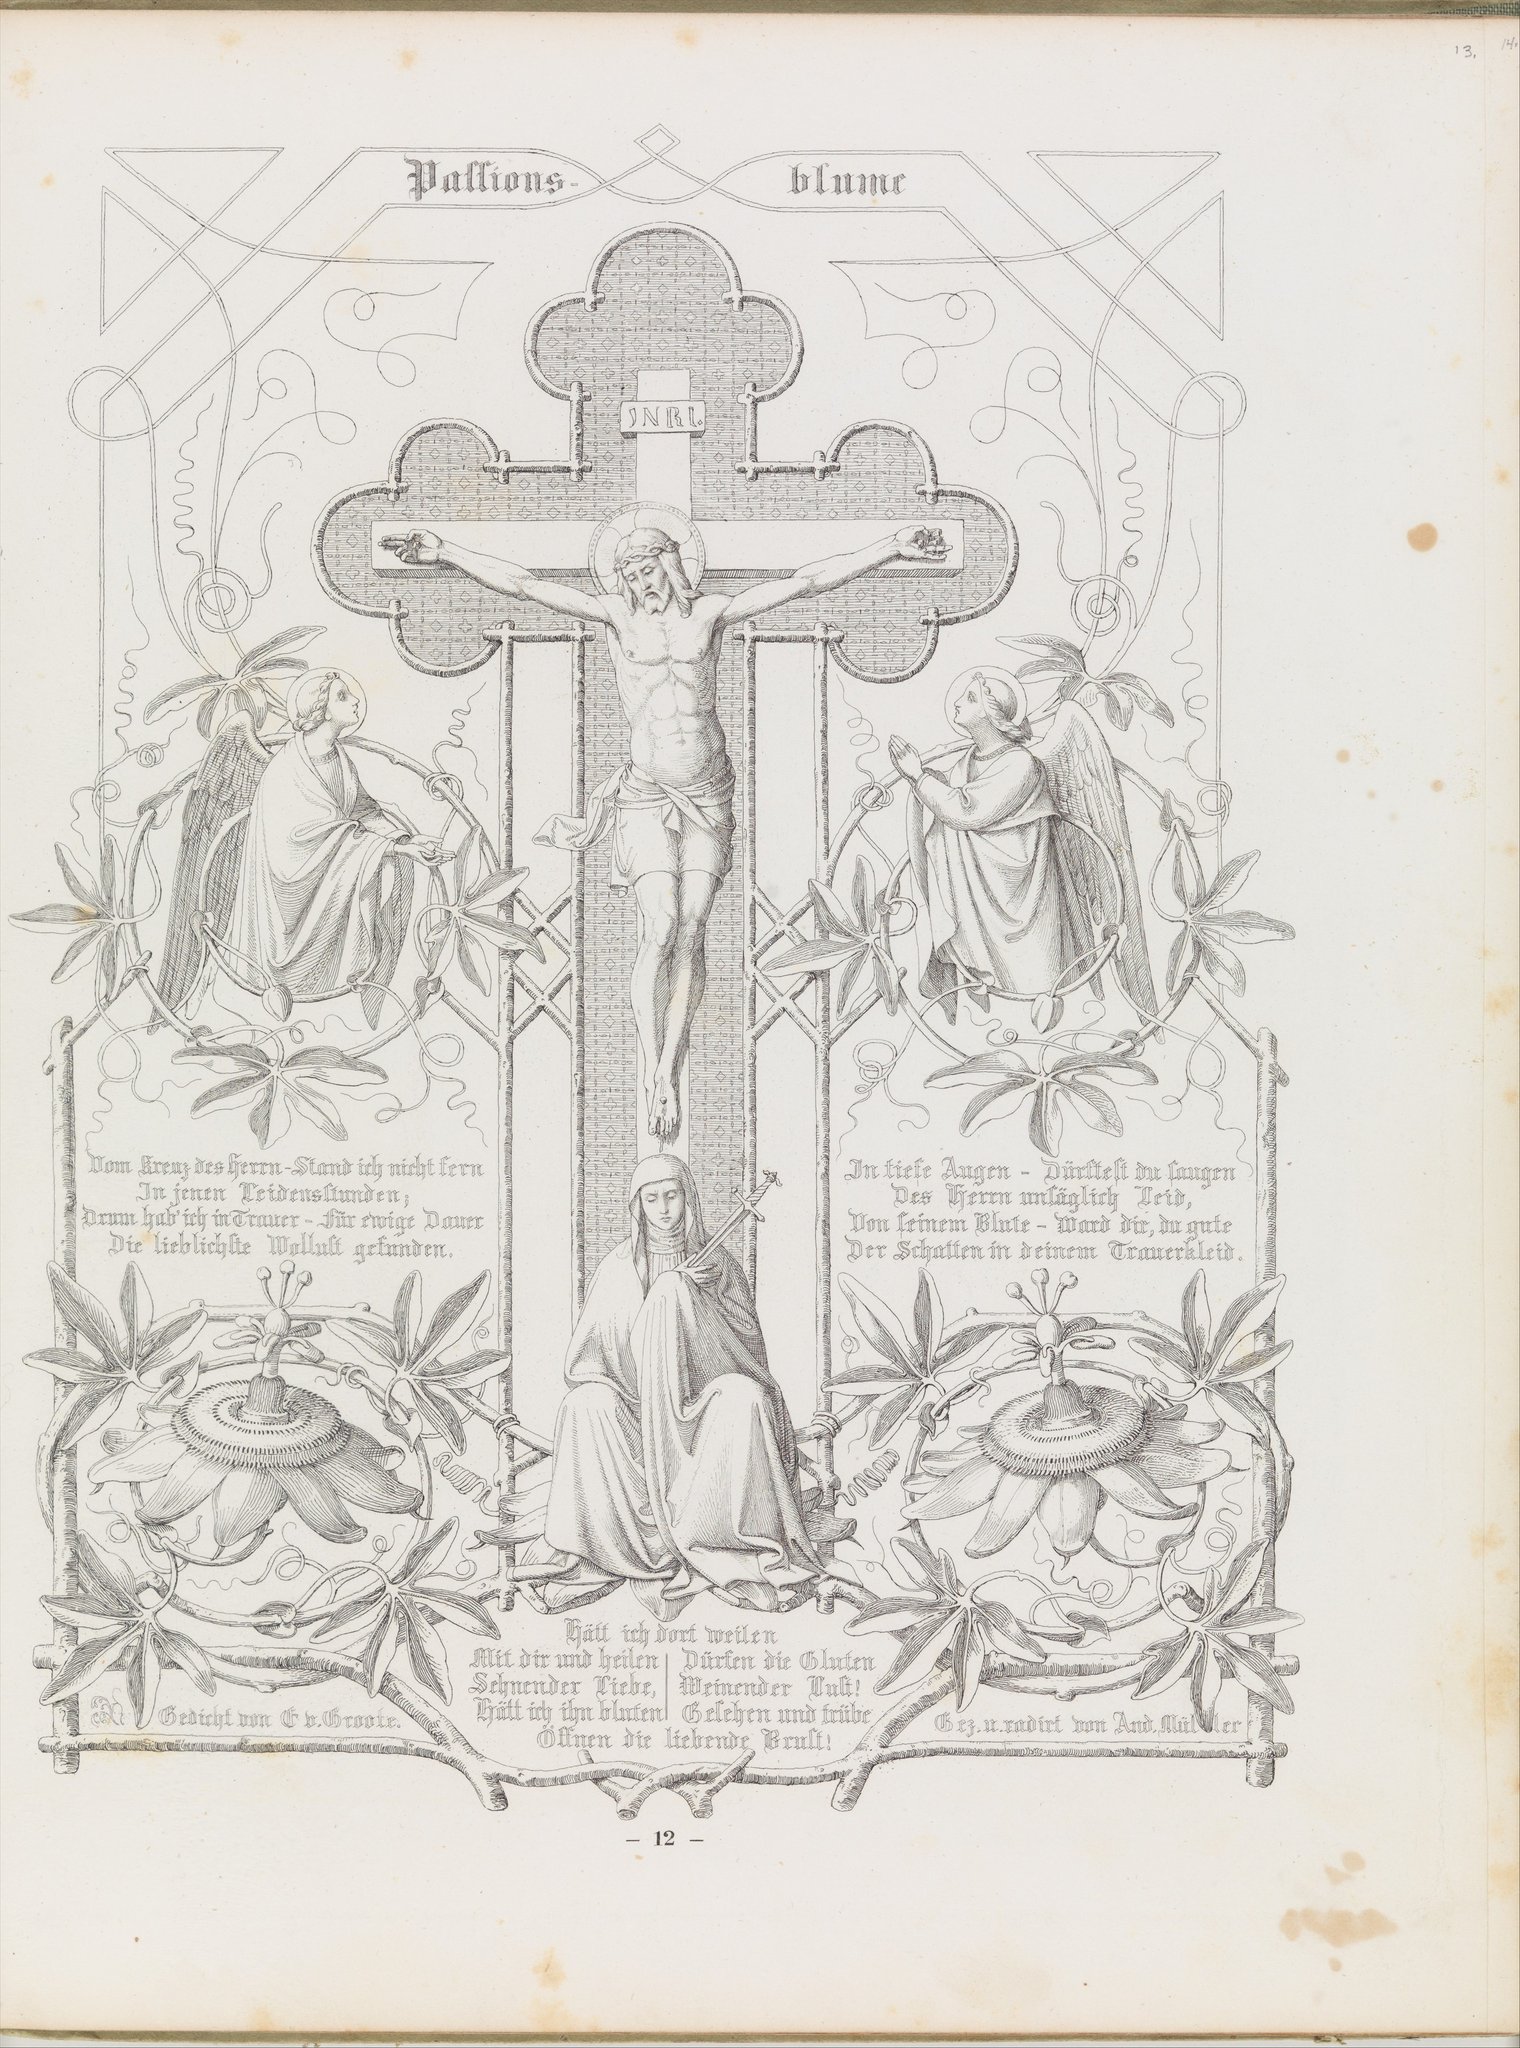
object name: book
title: Deutsche Dichtungen mit Randzeichnungen Deutscher Künstler. I. Band (Lider und Bilder, II)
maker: wilhelm camphausen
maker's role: artist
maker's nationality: german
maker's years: 1818-1885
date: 1843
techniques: etching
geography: germany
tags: women,christ,cross,crucifixion